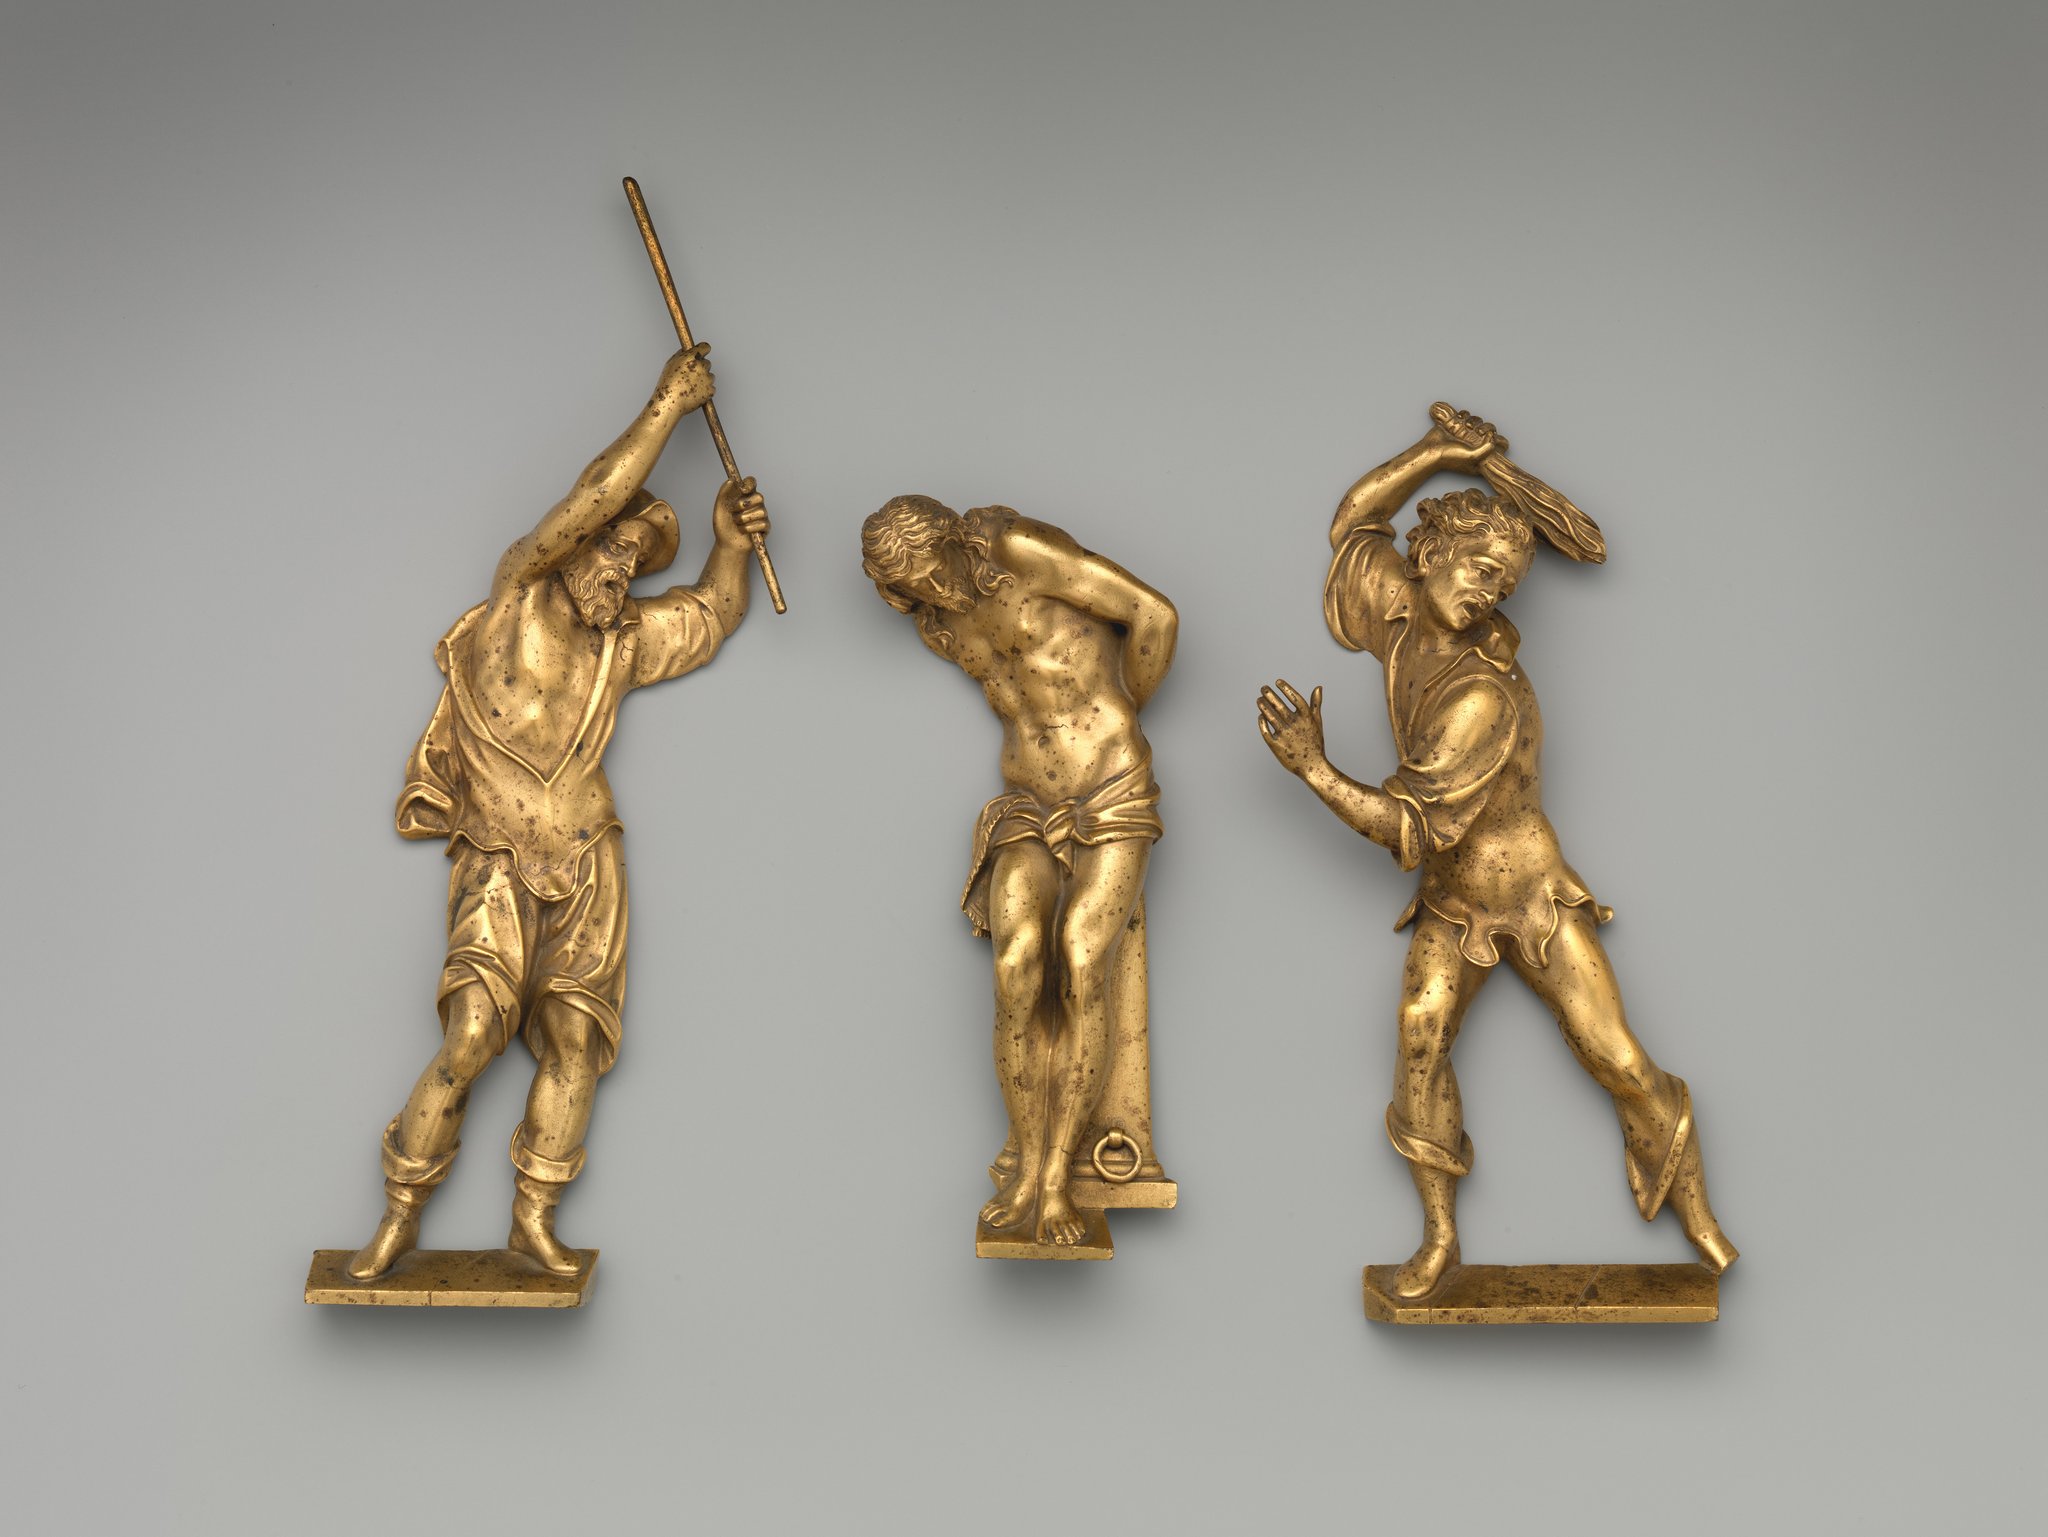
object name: relief group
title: The flagellation of Christ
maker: giambologna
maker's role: artist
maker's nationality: netherlandish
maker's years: 1529-1608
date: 1634-1666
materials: bronze, gilt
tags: men,christ